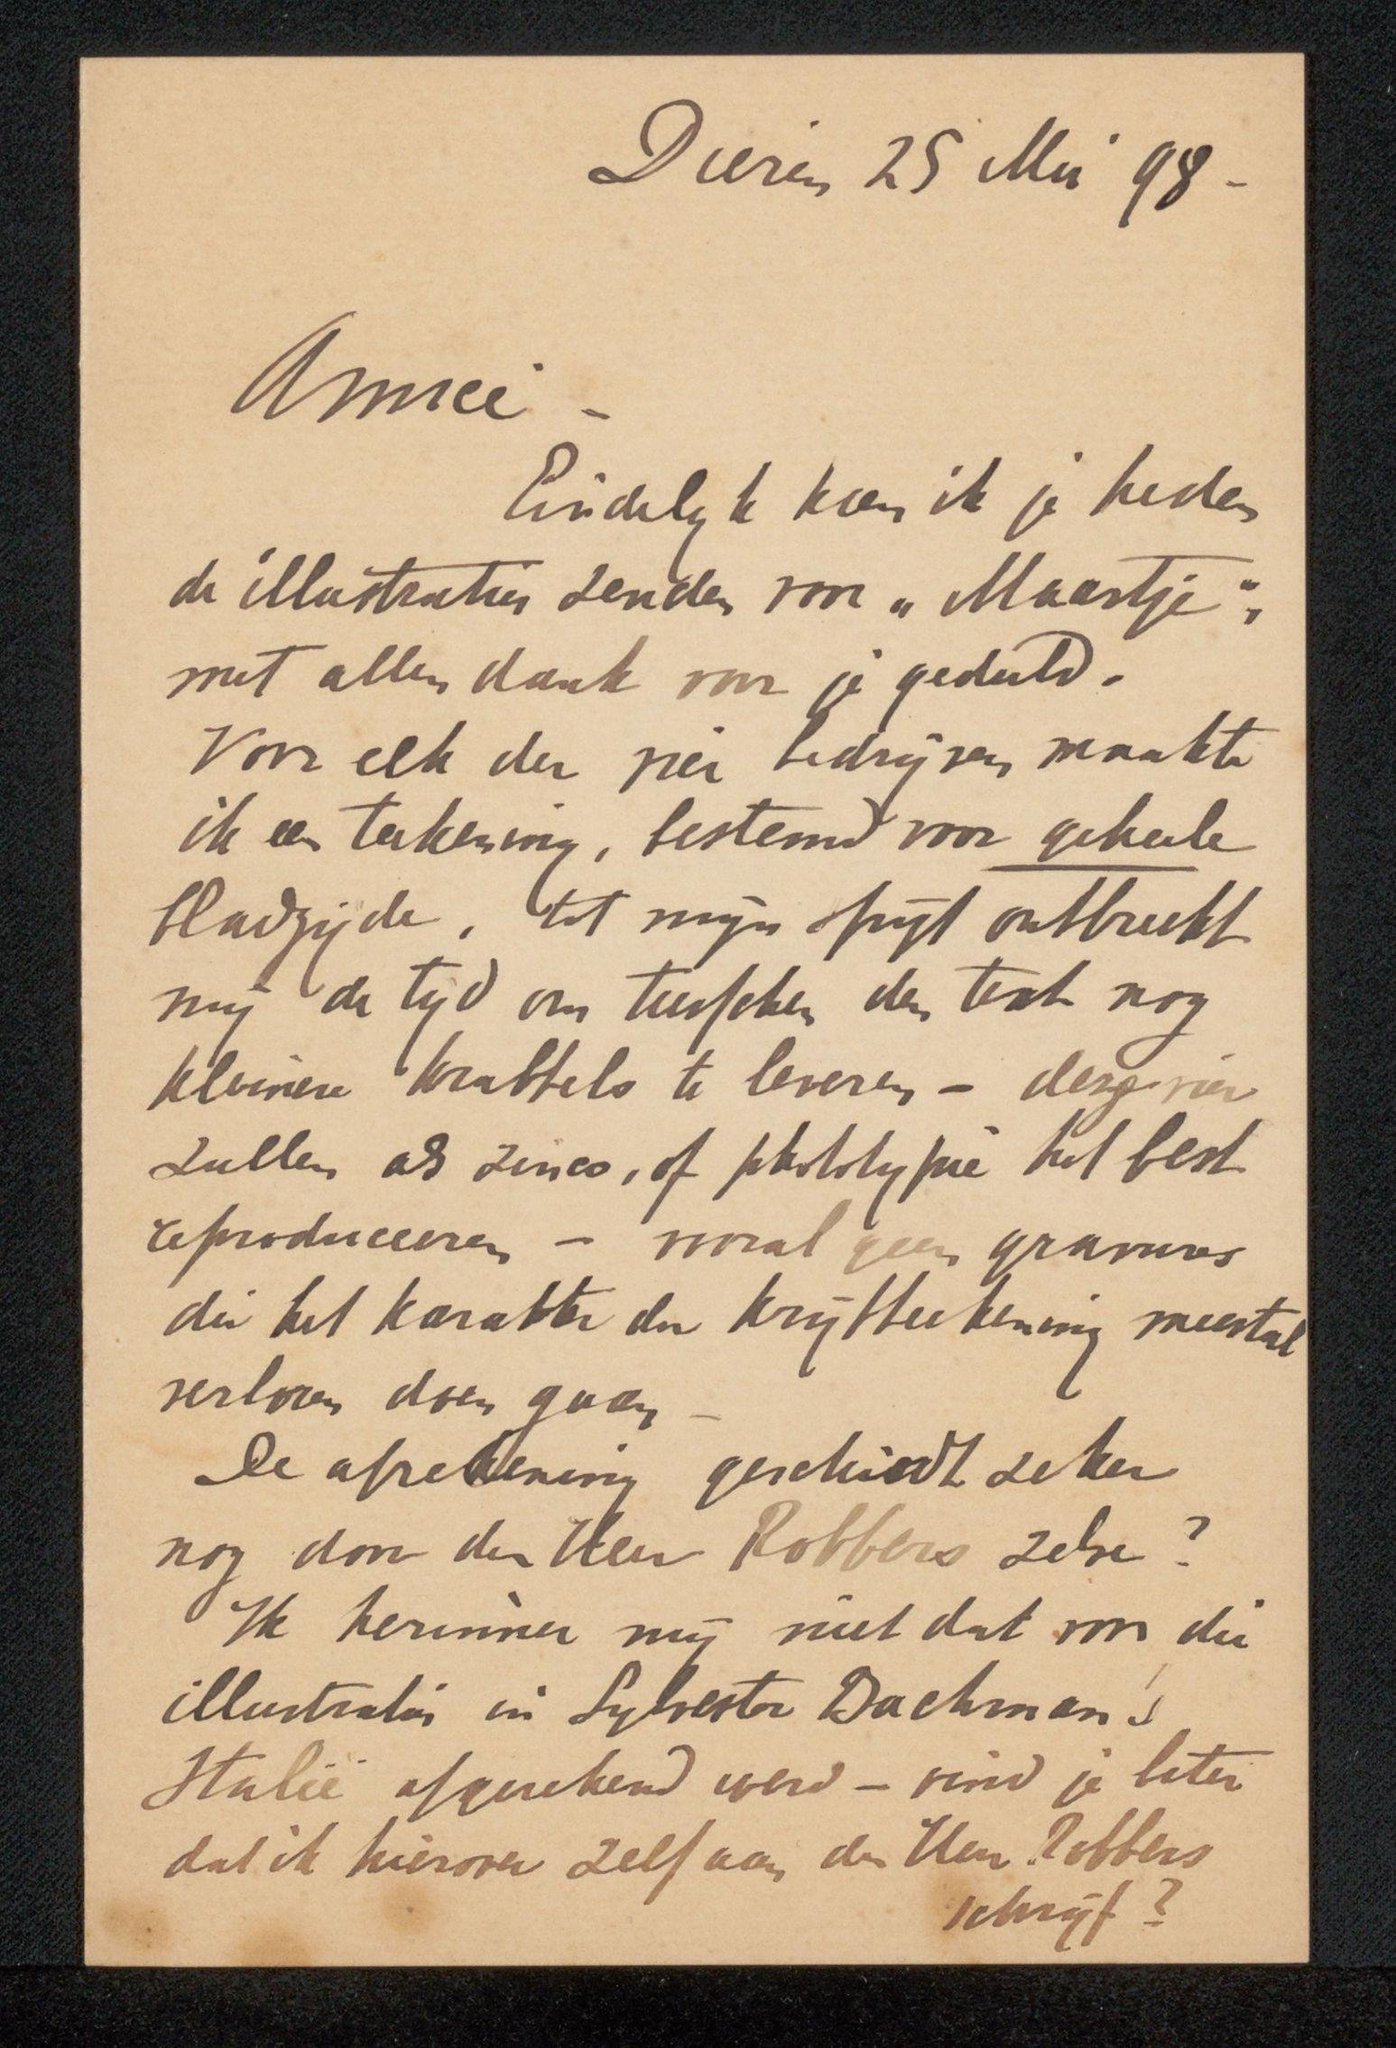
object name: letter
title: Brief aan Philip Zilcken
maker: pieter de josselin de jong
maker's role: draughtsman, painter, print maker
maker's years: 1861-1906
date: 1898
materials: ink, paper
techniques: writing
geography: dieren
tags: herman robbers, the hague, philip zilcken, drawing, literature ~ arts, the graphic arts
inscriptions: collector's mark: ‘RPK’